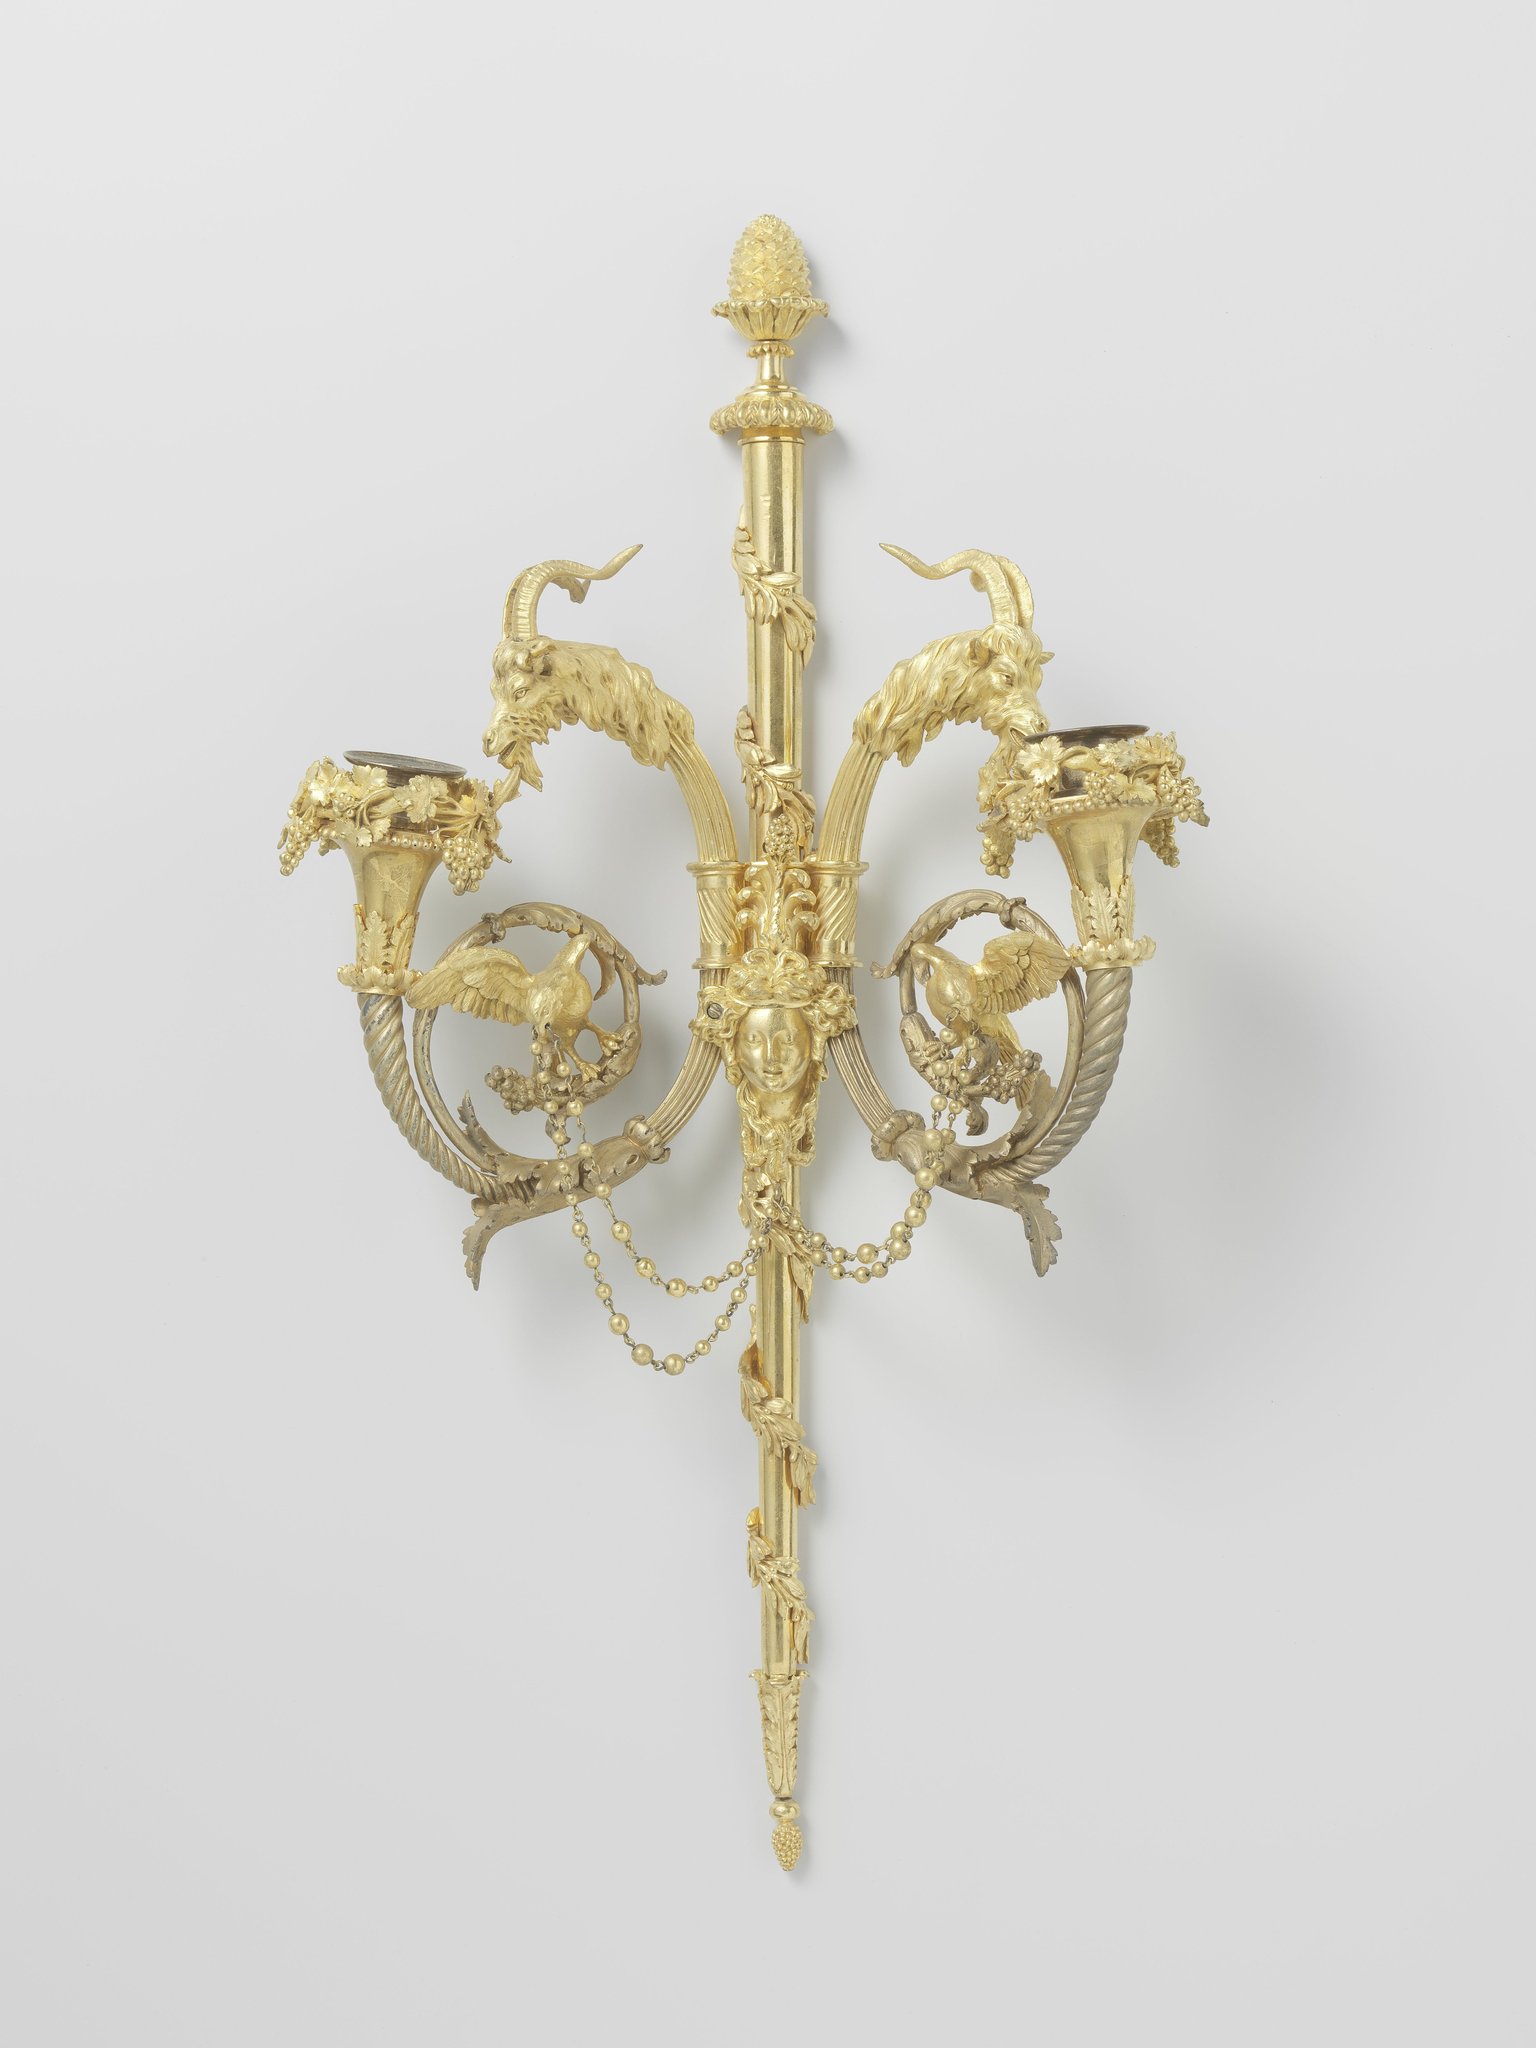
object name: sconce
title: Pair of wall lights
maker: Anonymous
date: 1780-1785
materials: bronze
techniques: gilding, silvering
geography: paris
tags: ram's head ~ ornament, mask, mascaron ~ ornament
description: The airy, elegant style of these wall lights is characteristic of the 1780s. The rams’ heads, the thyrsus (staff wound with laurel branches) and the bunches of grapes refer to Bacchus, the god of wine. Wall lights of this particular model were ordered by various members of the French royal family.